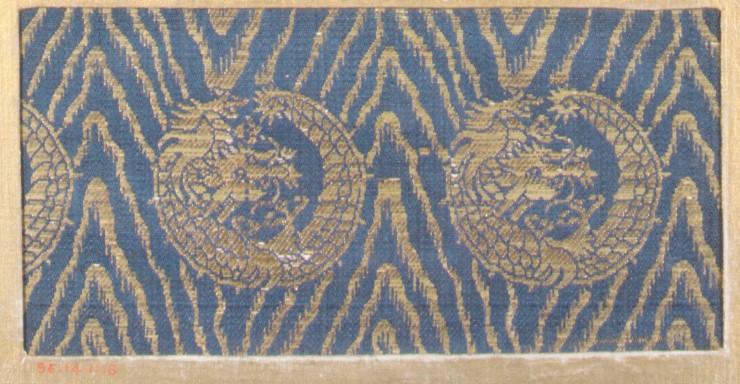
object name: piece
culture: japanese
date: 1701-1900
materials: silk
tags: dragons